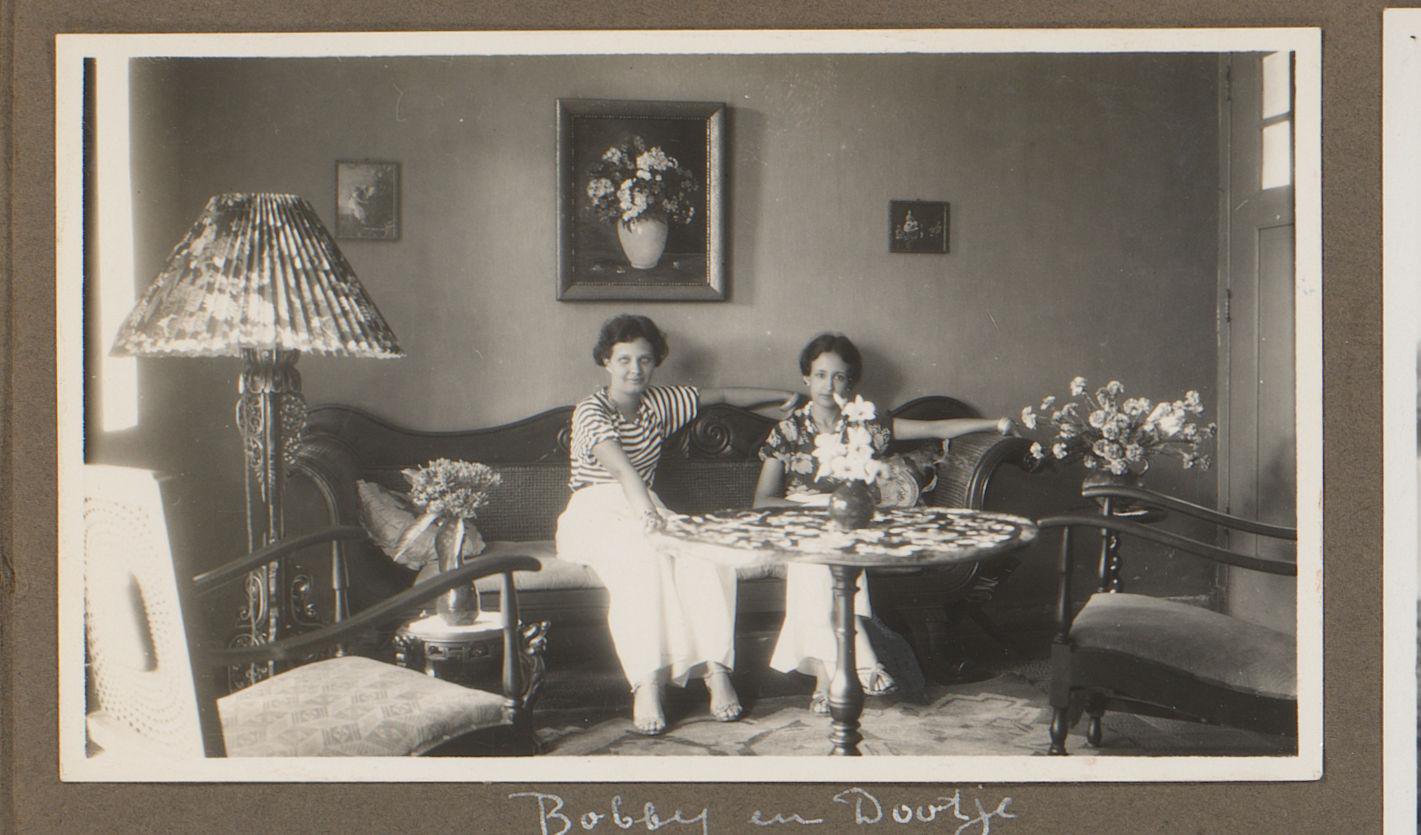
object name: photograph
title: Bobby en Dootje van Zijll de Jong in een woonkamer, Batavia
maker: Anonymous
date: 1933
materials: paper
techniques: gelatin silver print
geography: batavia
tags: historical persons - bb - woman, living-room, parlour, sitting-room, batavia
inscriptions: inscription: ‘Bobby en Dootje’